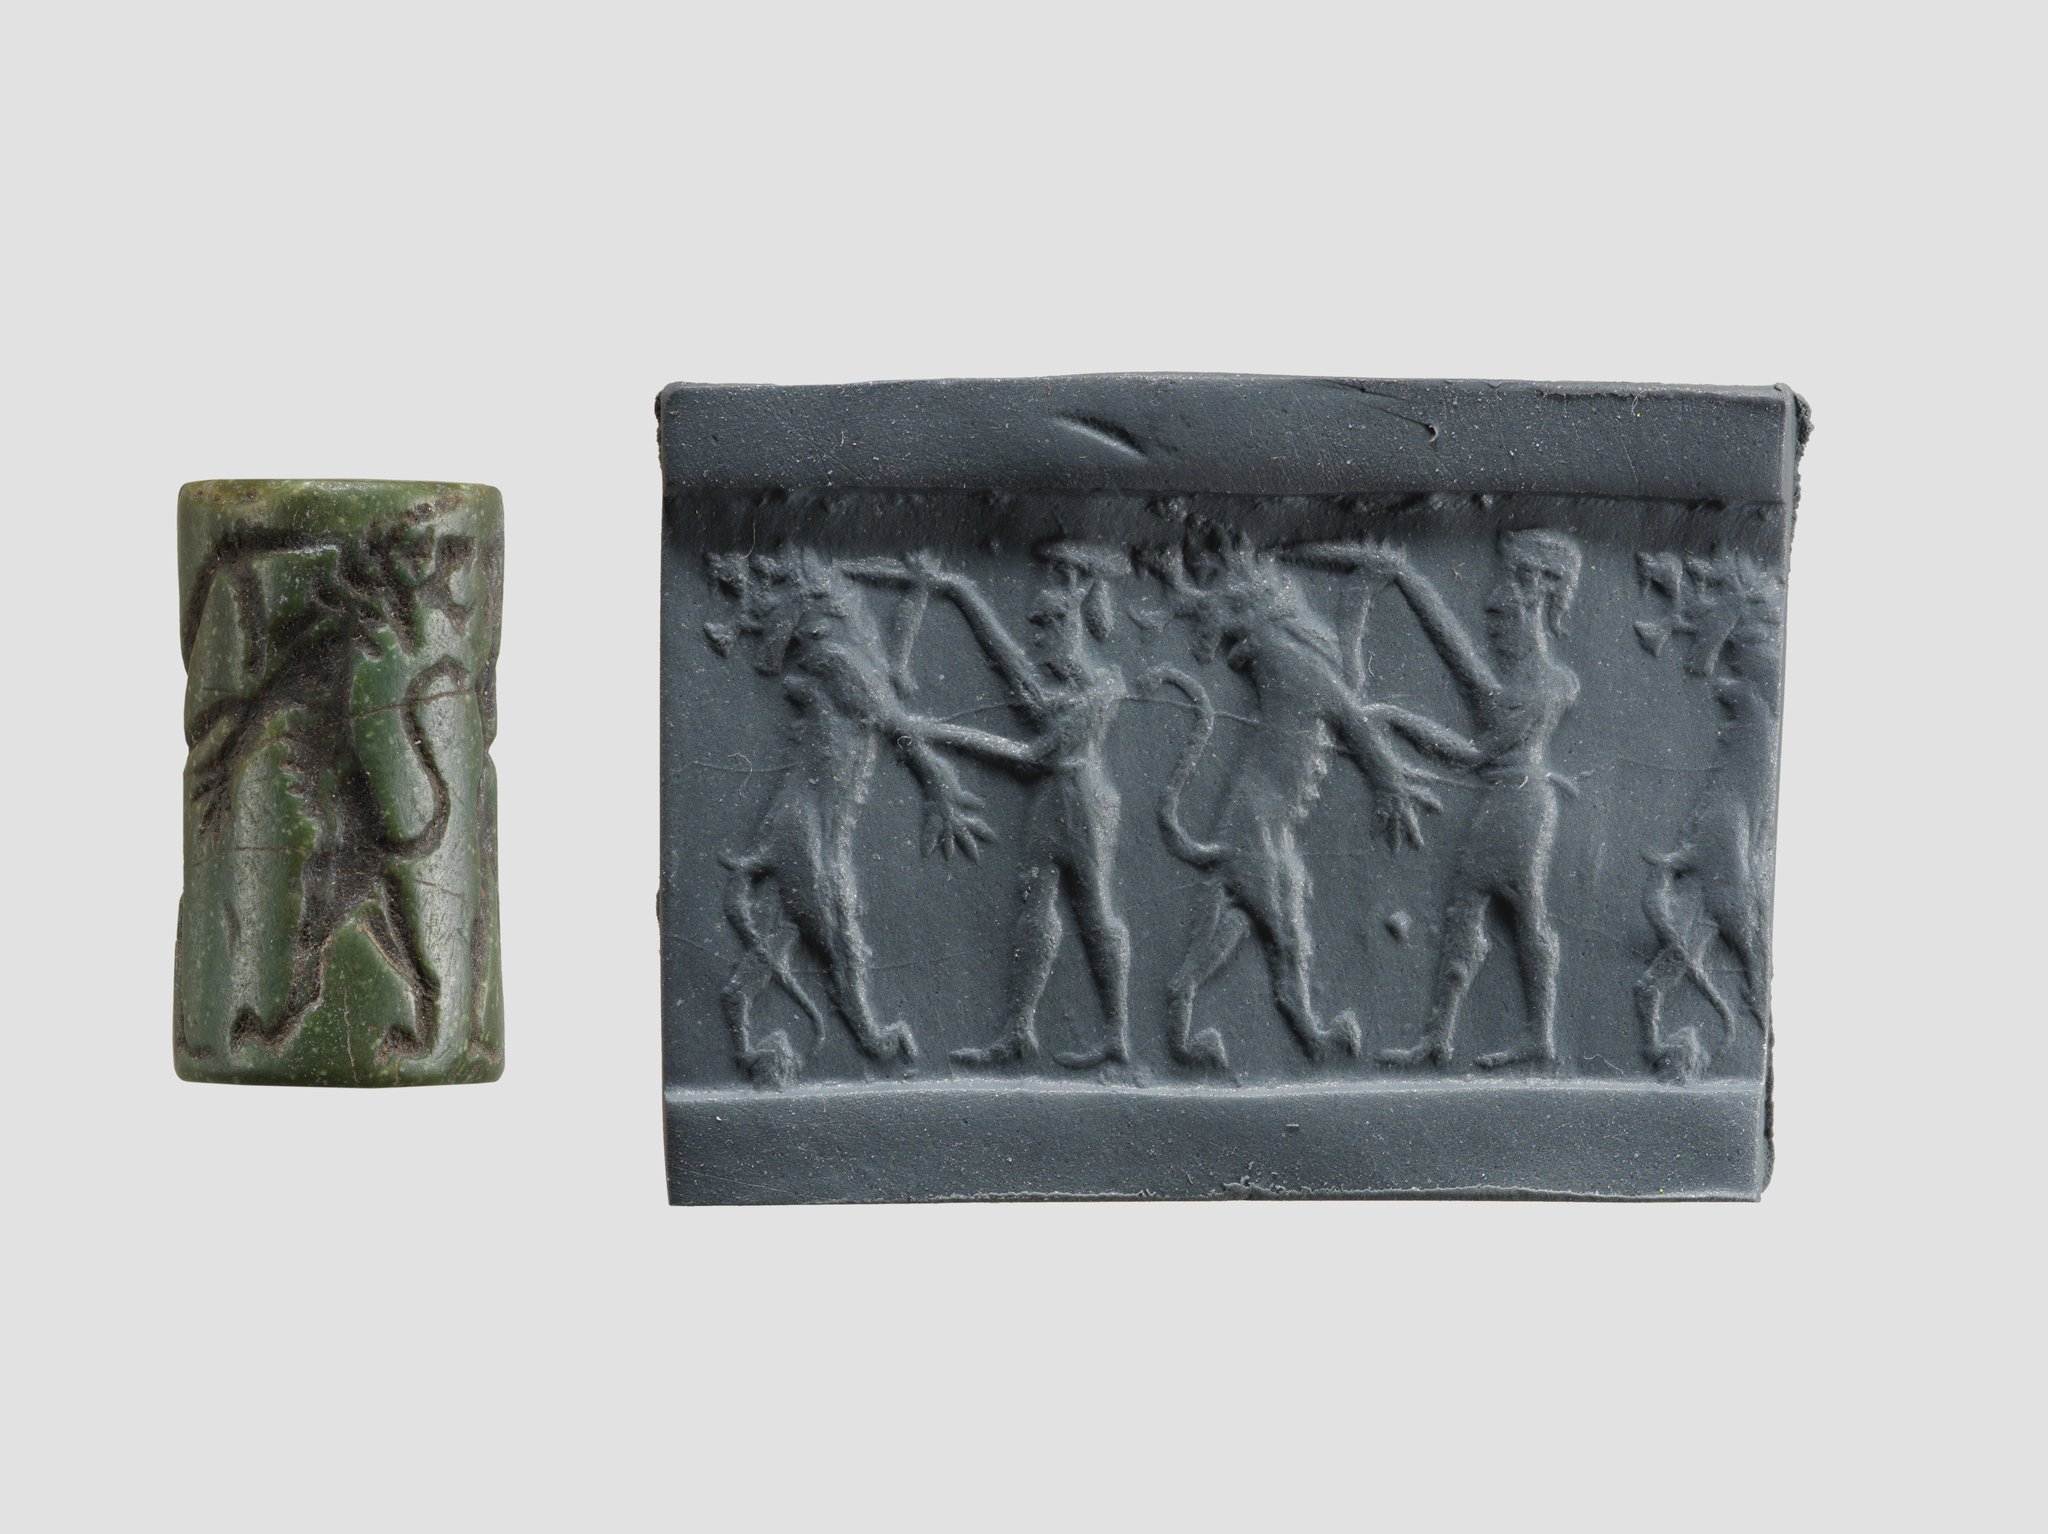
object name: cylinder seal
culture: akkadian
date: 2350-2150 BCE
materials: stone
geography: mesopotamia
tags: animals